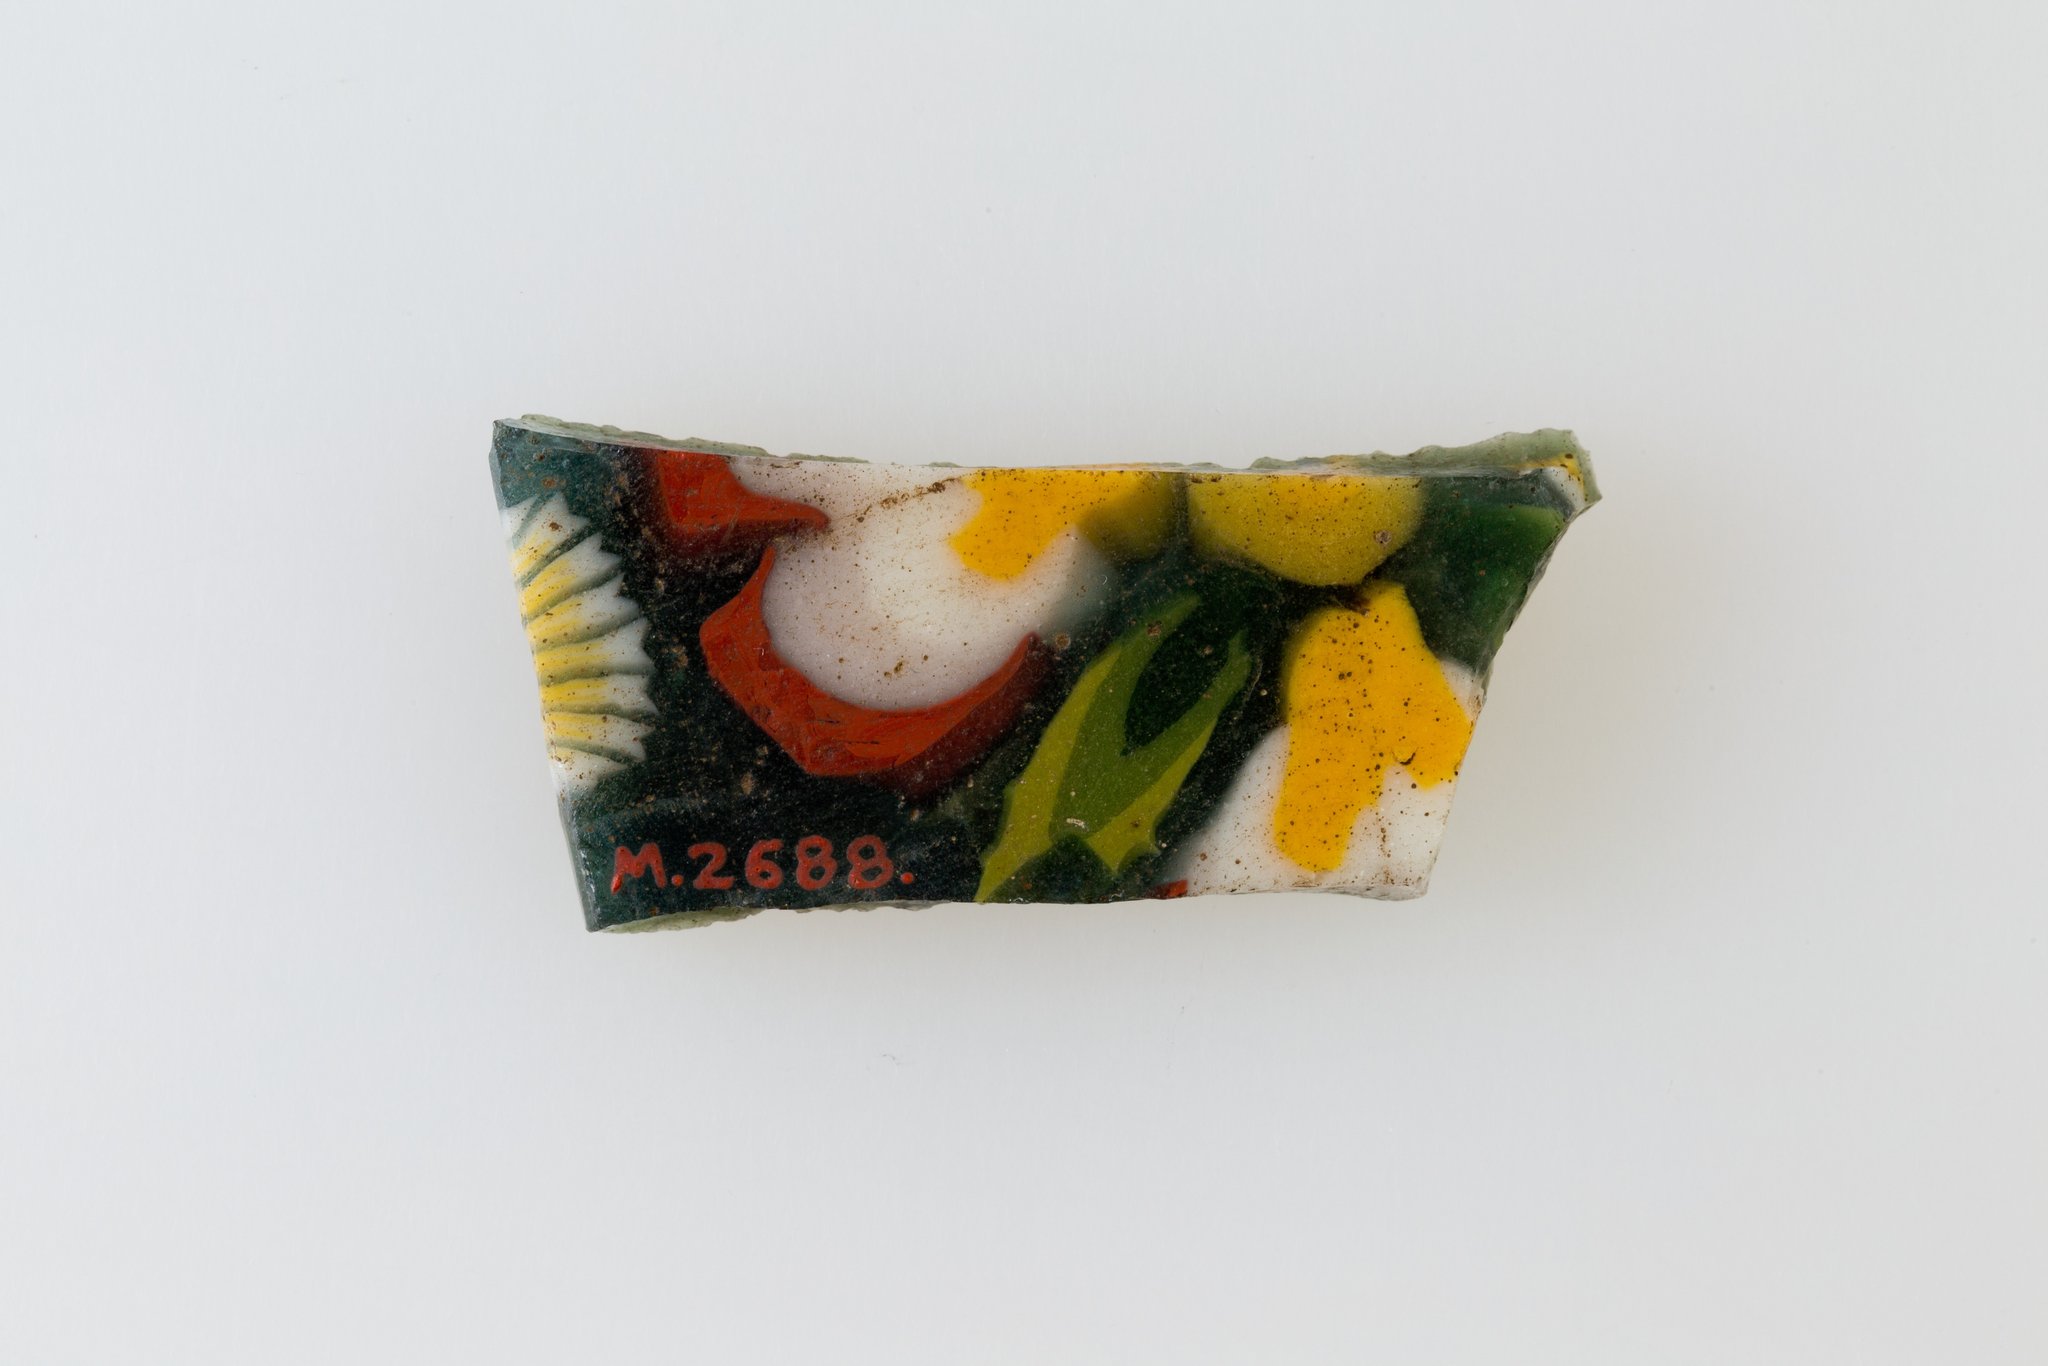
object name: plaque, floral, inlay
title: Floral plaque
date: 100 BCE-100 CE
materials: glass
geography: egypt